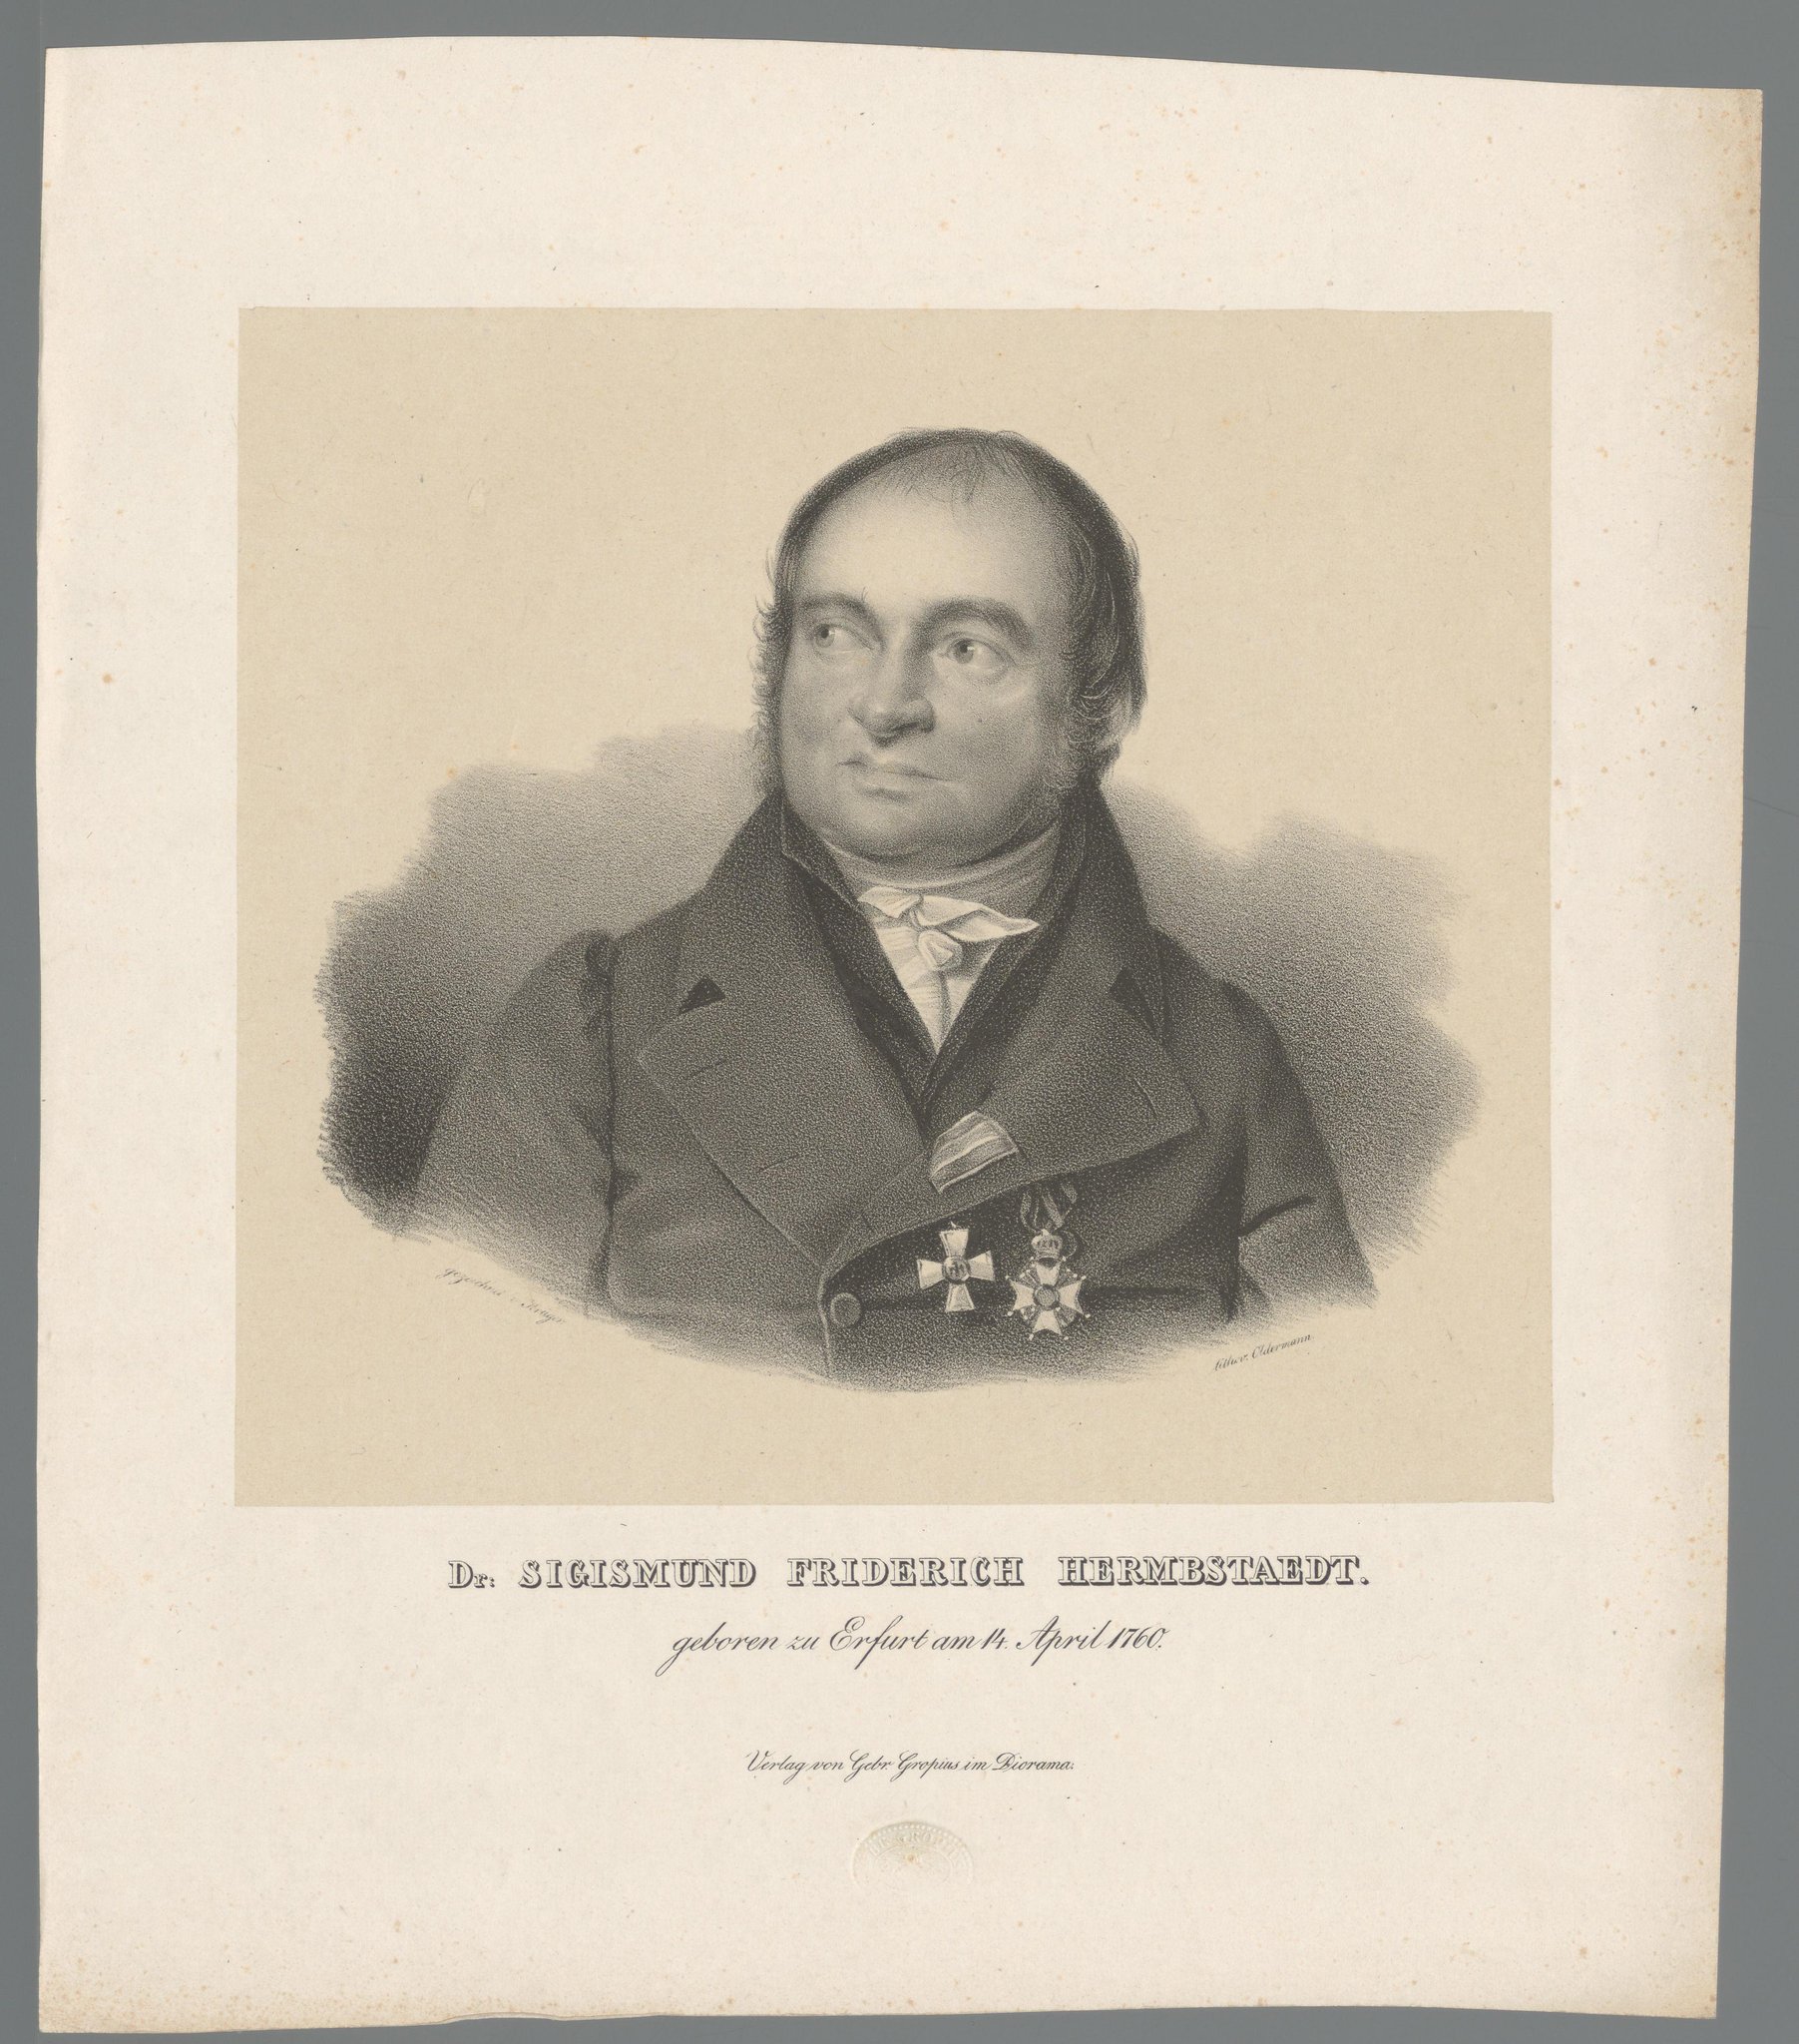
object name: print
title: Dr. Sigismund Friderich Hermbstaedt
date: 1812-1874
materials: paper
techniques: lithograph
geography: berlin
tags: berlin, sigismund friedrich hermbstaedt, pharmacist, druggist, apothecary; pharmacy, drugstore, dispensing chemist, historical persons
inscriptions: check stamp: Lugt 5415, collector's mark: Lugt 2228